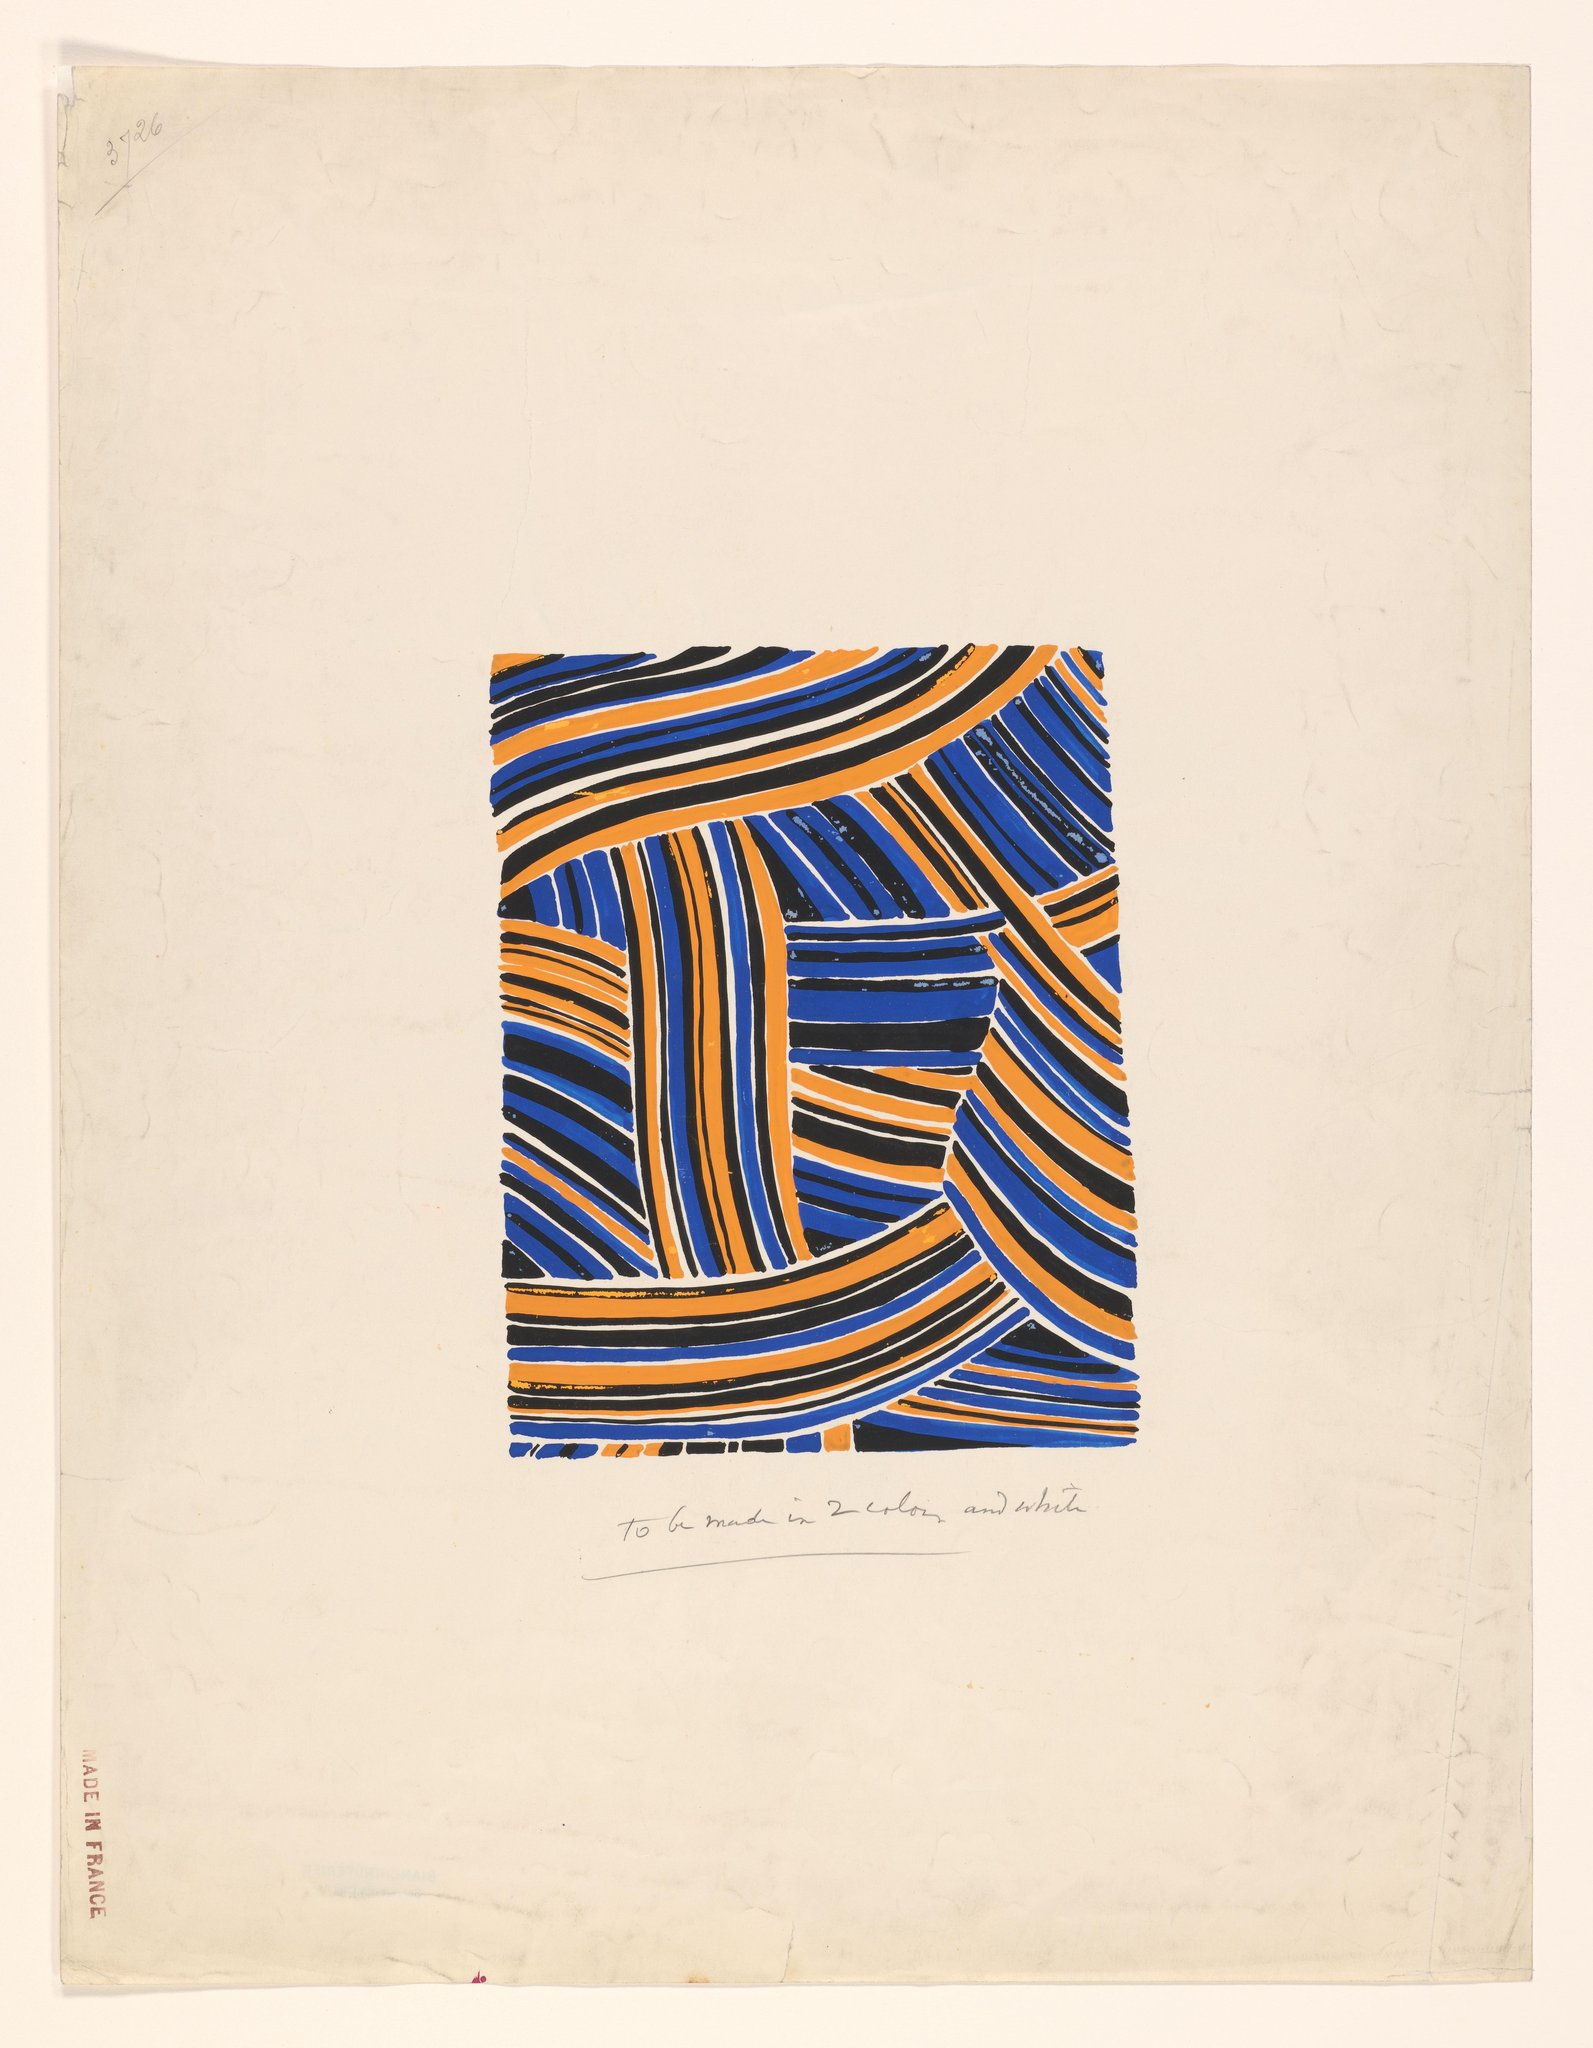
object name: design drawing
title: Ontwerp voor een zijden stof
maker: Anonymous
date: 1938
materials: gouache, paper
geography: lyon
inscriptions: stamp: ‘BIANCHINI FERIER / Service Recherche’, inscription: ‘To be made in 2 colours and white’, stamp: ‘MADE IN FRANCE’, number: ‘3726’